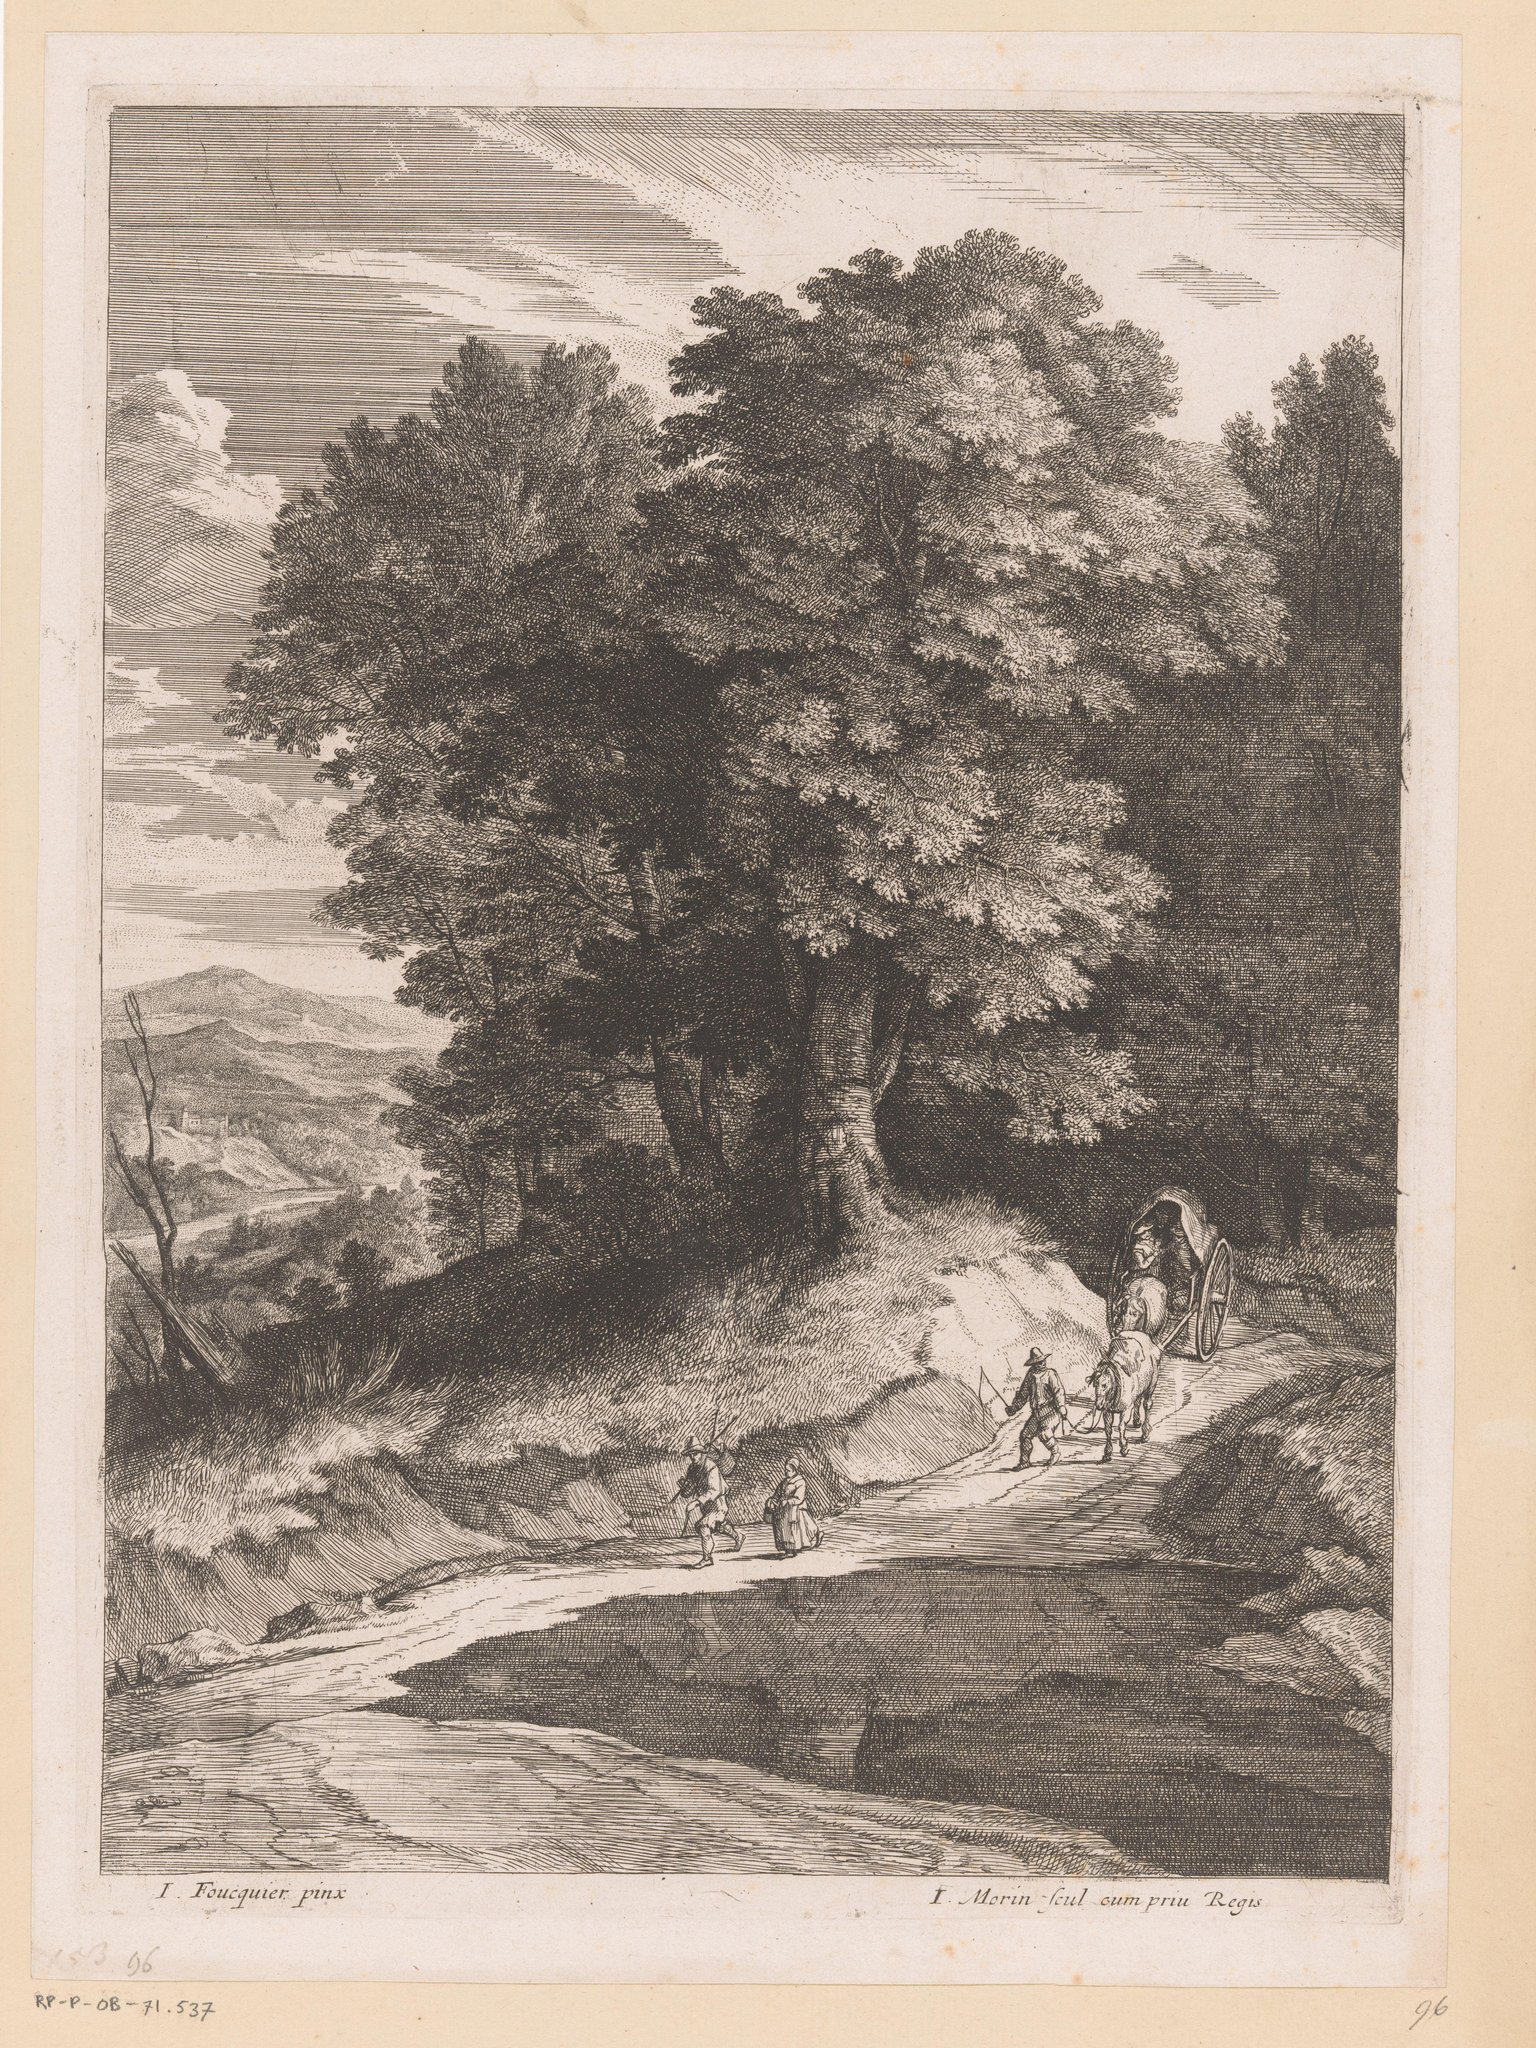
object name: print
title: Landschap met reizigers met een kar op een pad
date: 1625-1650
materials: paper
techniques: engraving, etching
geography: france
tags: road, path, landscapes in the temperate zone (+ landscape with figures, staffage), (farm) wagon, freight wagon, cart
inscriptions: collector's mark: Lugt 240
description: Maakt deel uit van een vierdelige serie met landschappen met hoge bomen.